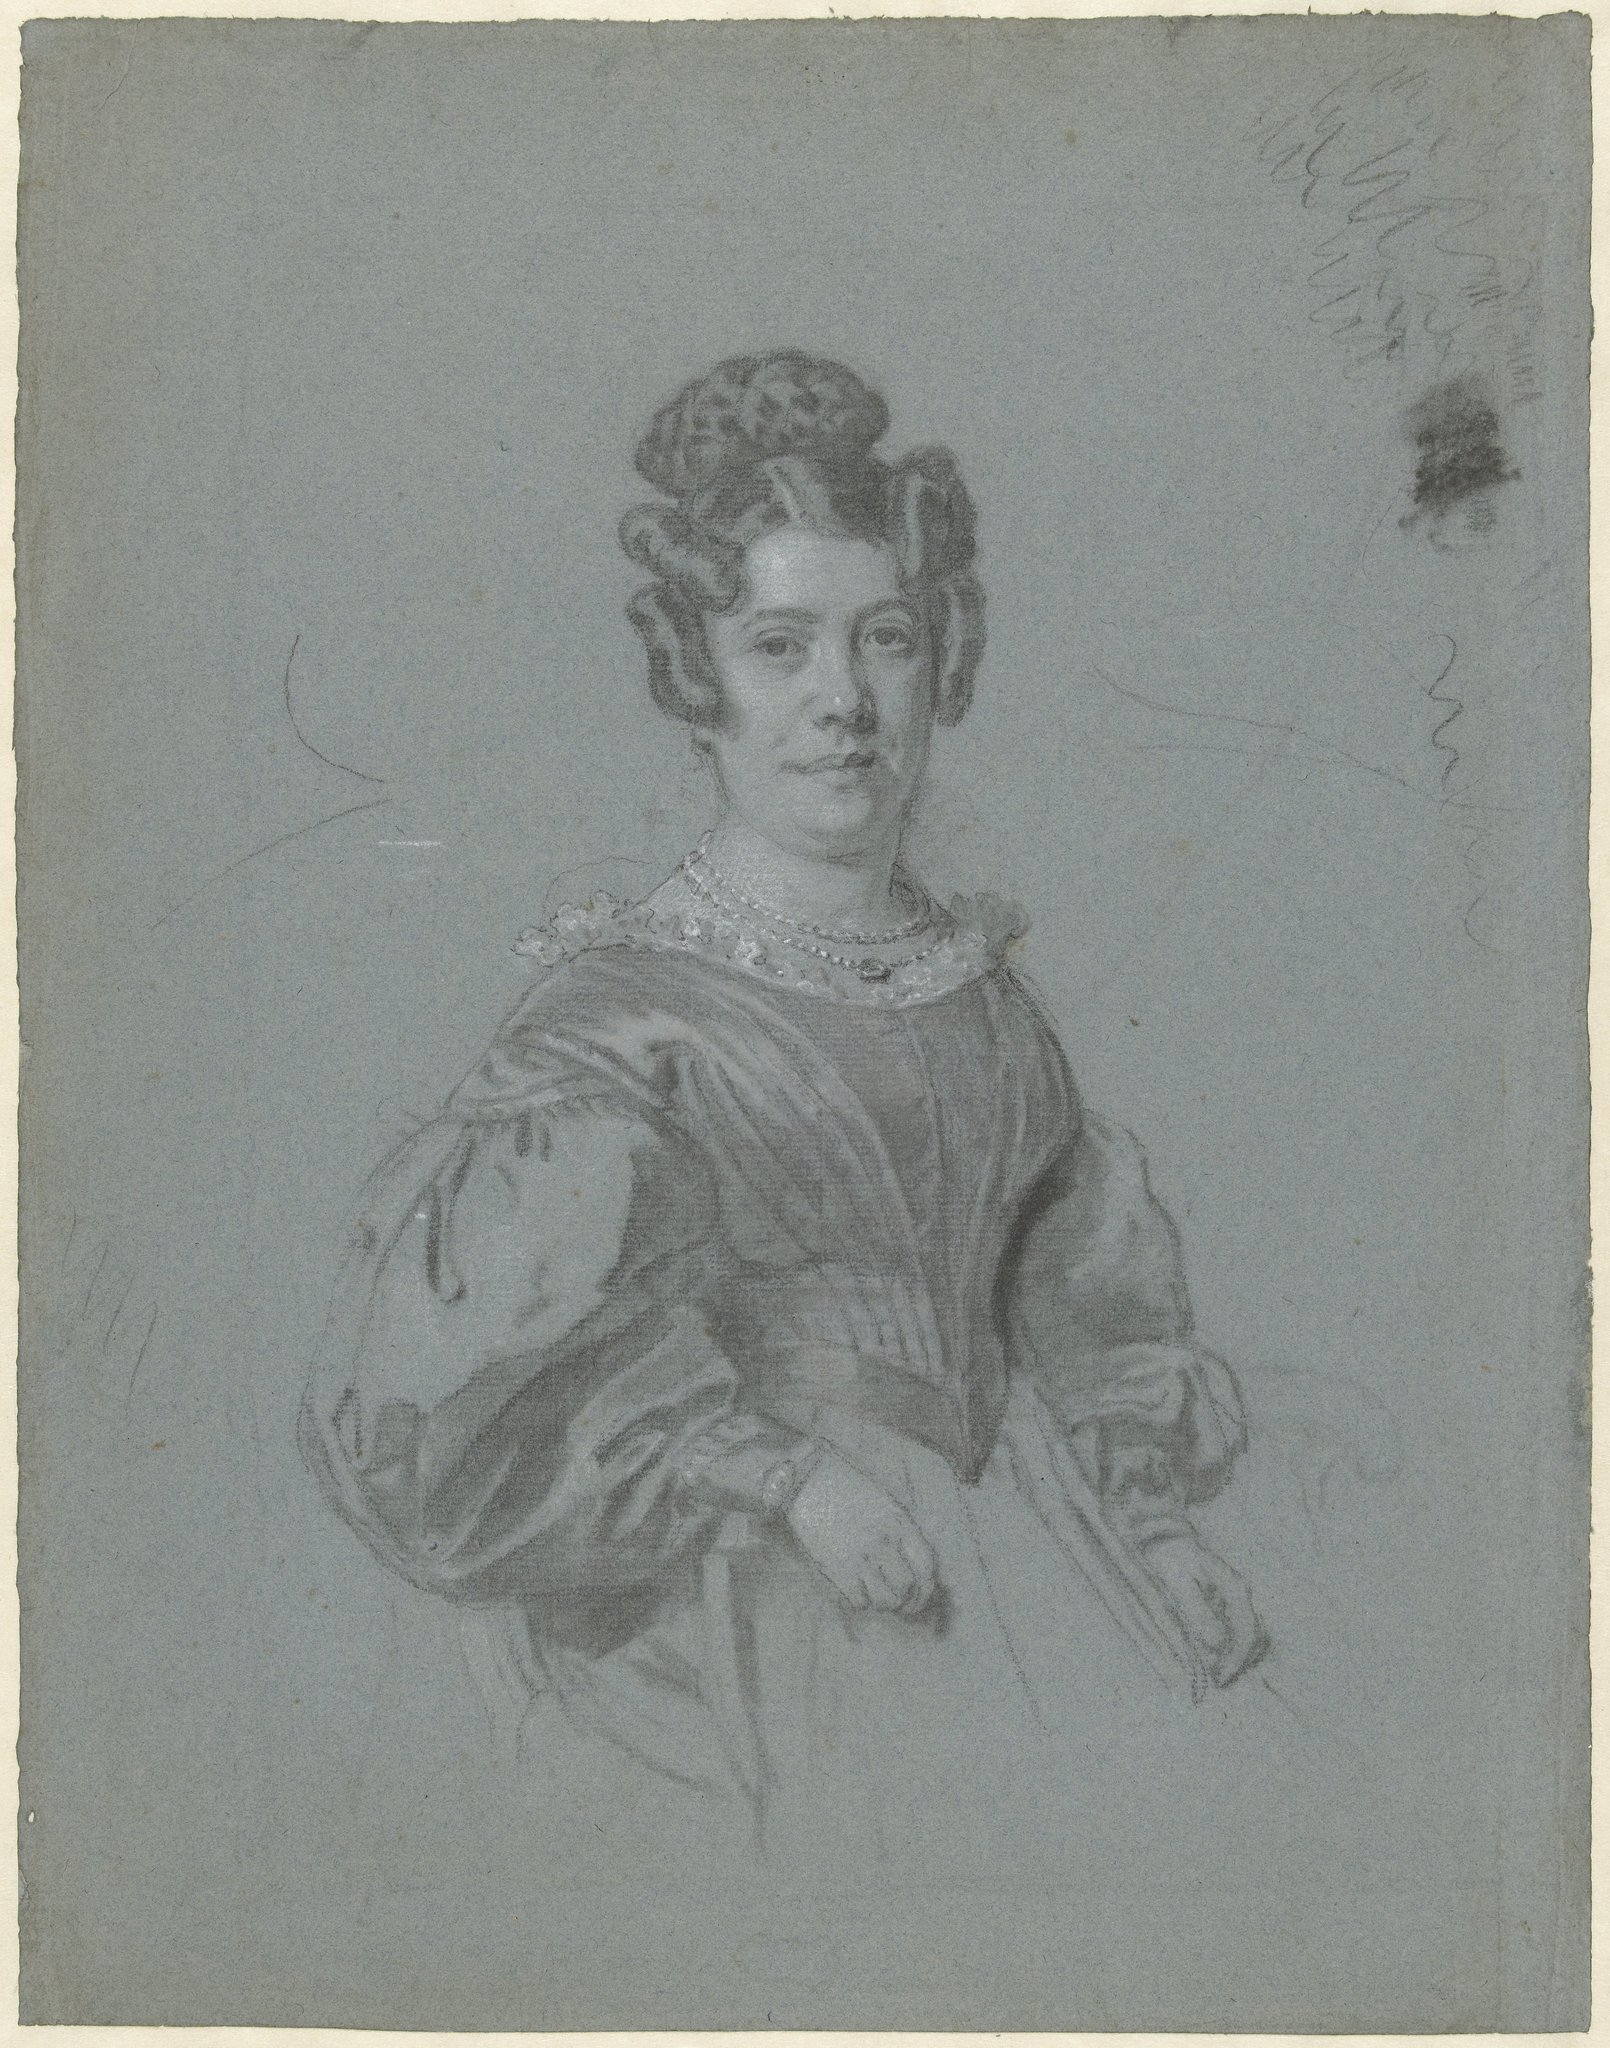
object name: drawing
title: Voorstudie voor het portret van Aleida Maria Engelberts, echtgenote van prof. Hendrik Cock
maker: charles howard hodges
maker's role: draughtsman, painter, print maker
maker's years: 1764-1837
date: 1774-1837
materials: chalk, paper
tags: leiden, historical persons